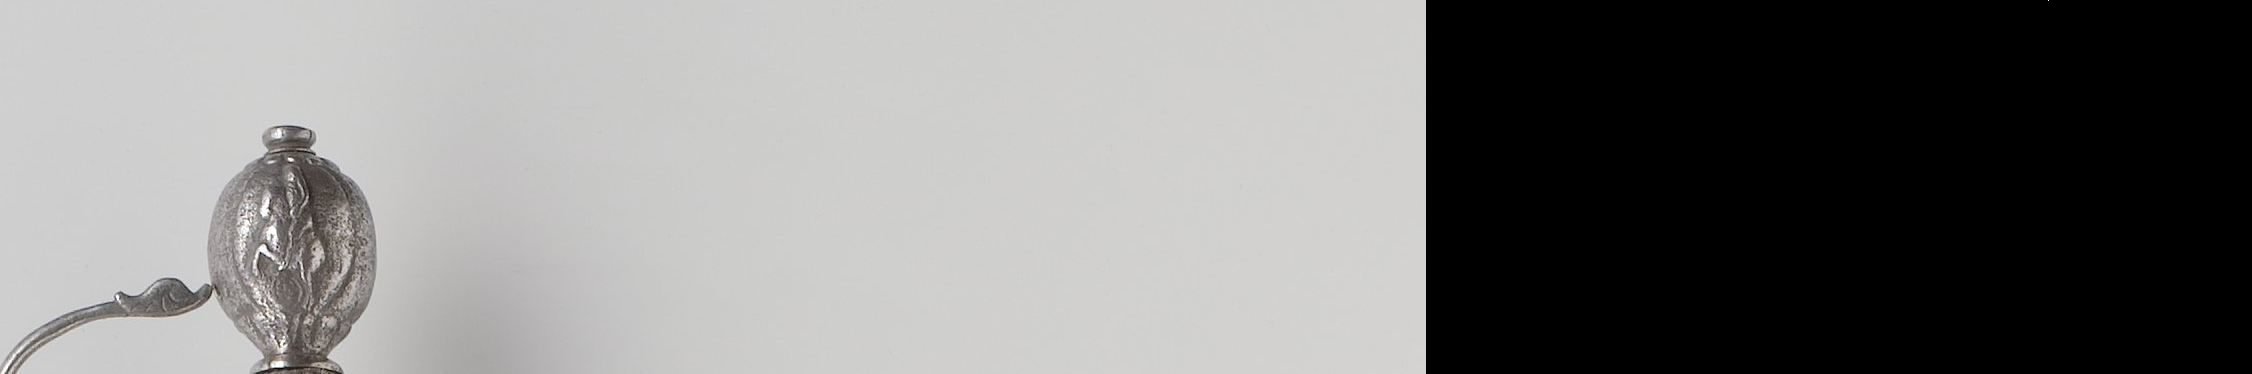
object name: sword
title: Degen met gebeiteld ijzeren gevest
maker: Anonymous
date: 1655-1665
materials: iron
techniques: printing, embroidery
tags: riding a horse, ass, or mule; rider, horseman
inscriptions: mark, signature: ‘TOMAS (draagzijde) en DE ALLA (buitenzijde)’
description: Het gevest is gebeiteld met voornamelijk ruiters en paarden: een ajour bewerkt paard op de vuistbeugel, groteske maskers in de vorm van een hondenkop en op de stootplaat groepen ruiters, bovenop in bas-relïef, onderop in hoogreliëf; de greep is omwonden met een authentieke greepwikkeling van koperdraad met aan weerszijden gevlochten greepringen. De tweesnijdige kling met ruitvormige doorsnede heeft op elk vlak een diepe in het midden liggende geul met de gestempelde signaturen TOMAS en DE ALLA, en een globe precies onder de geul.